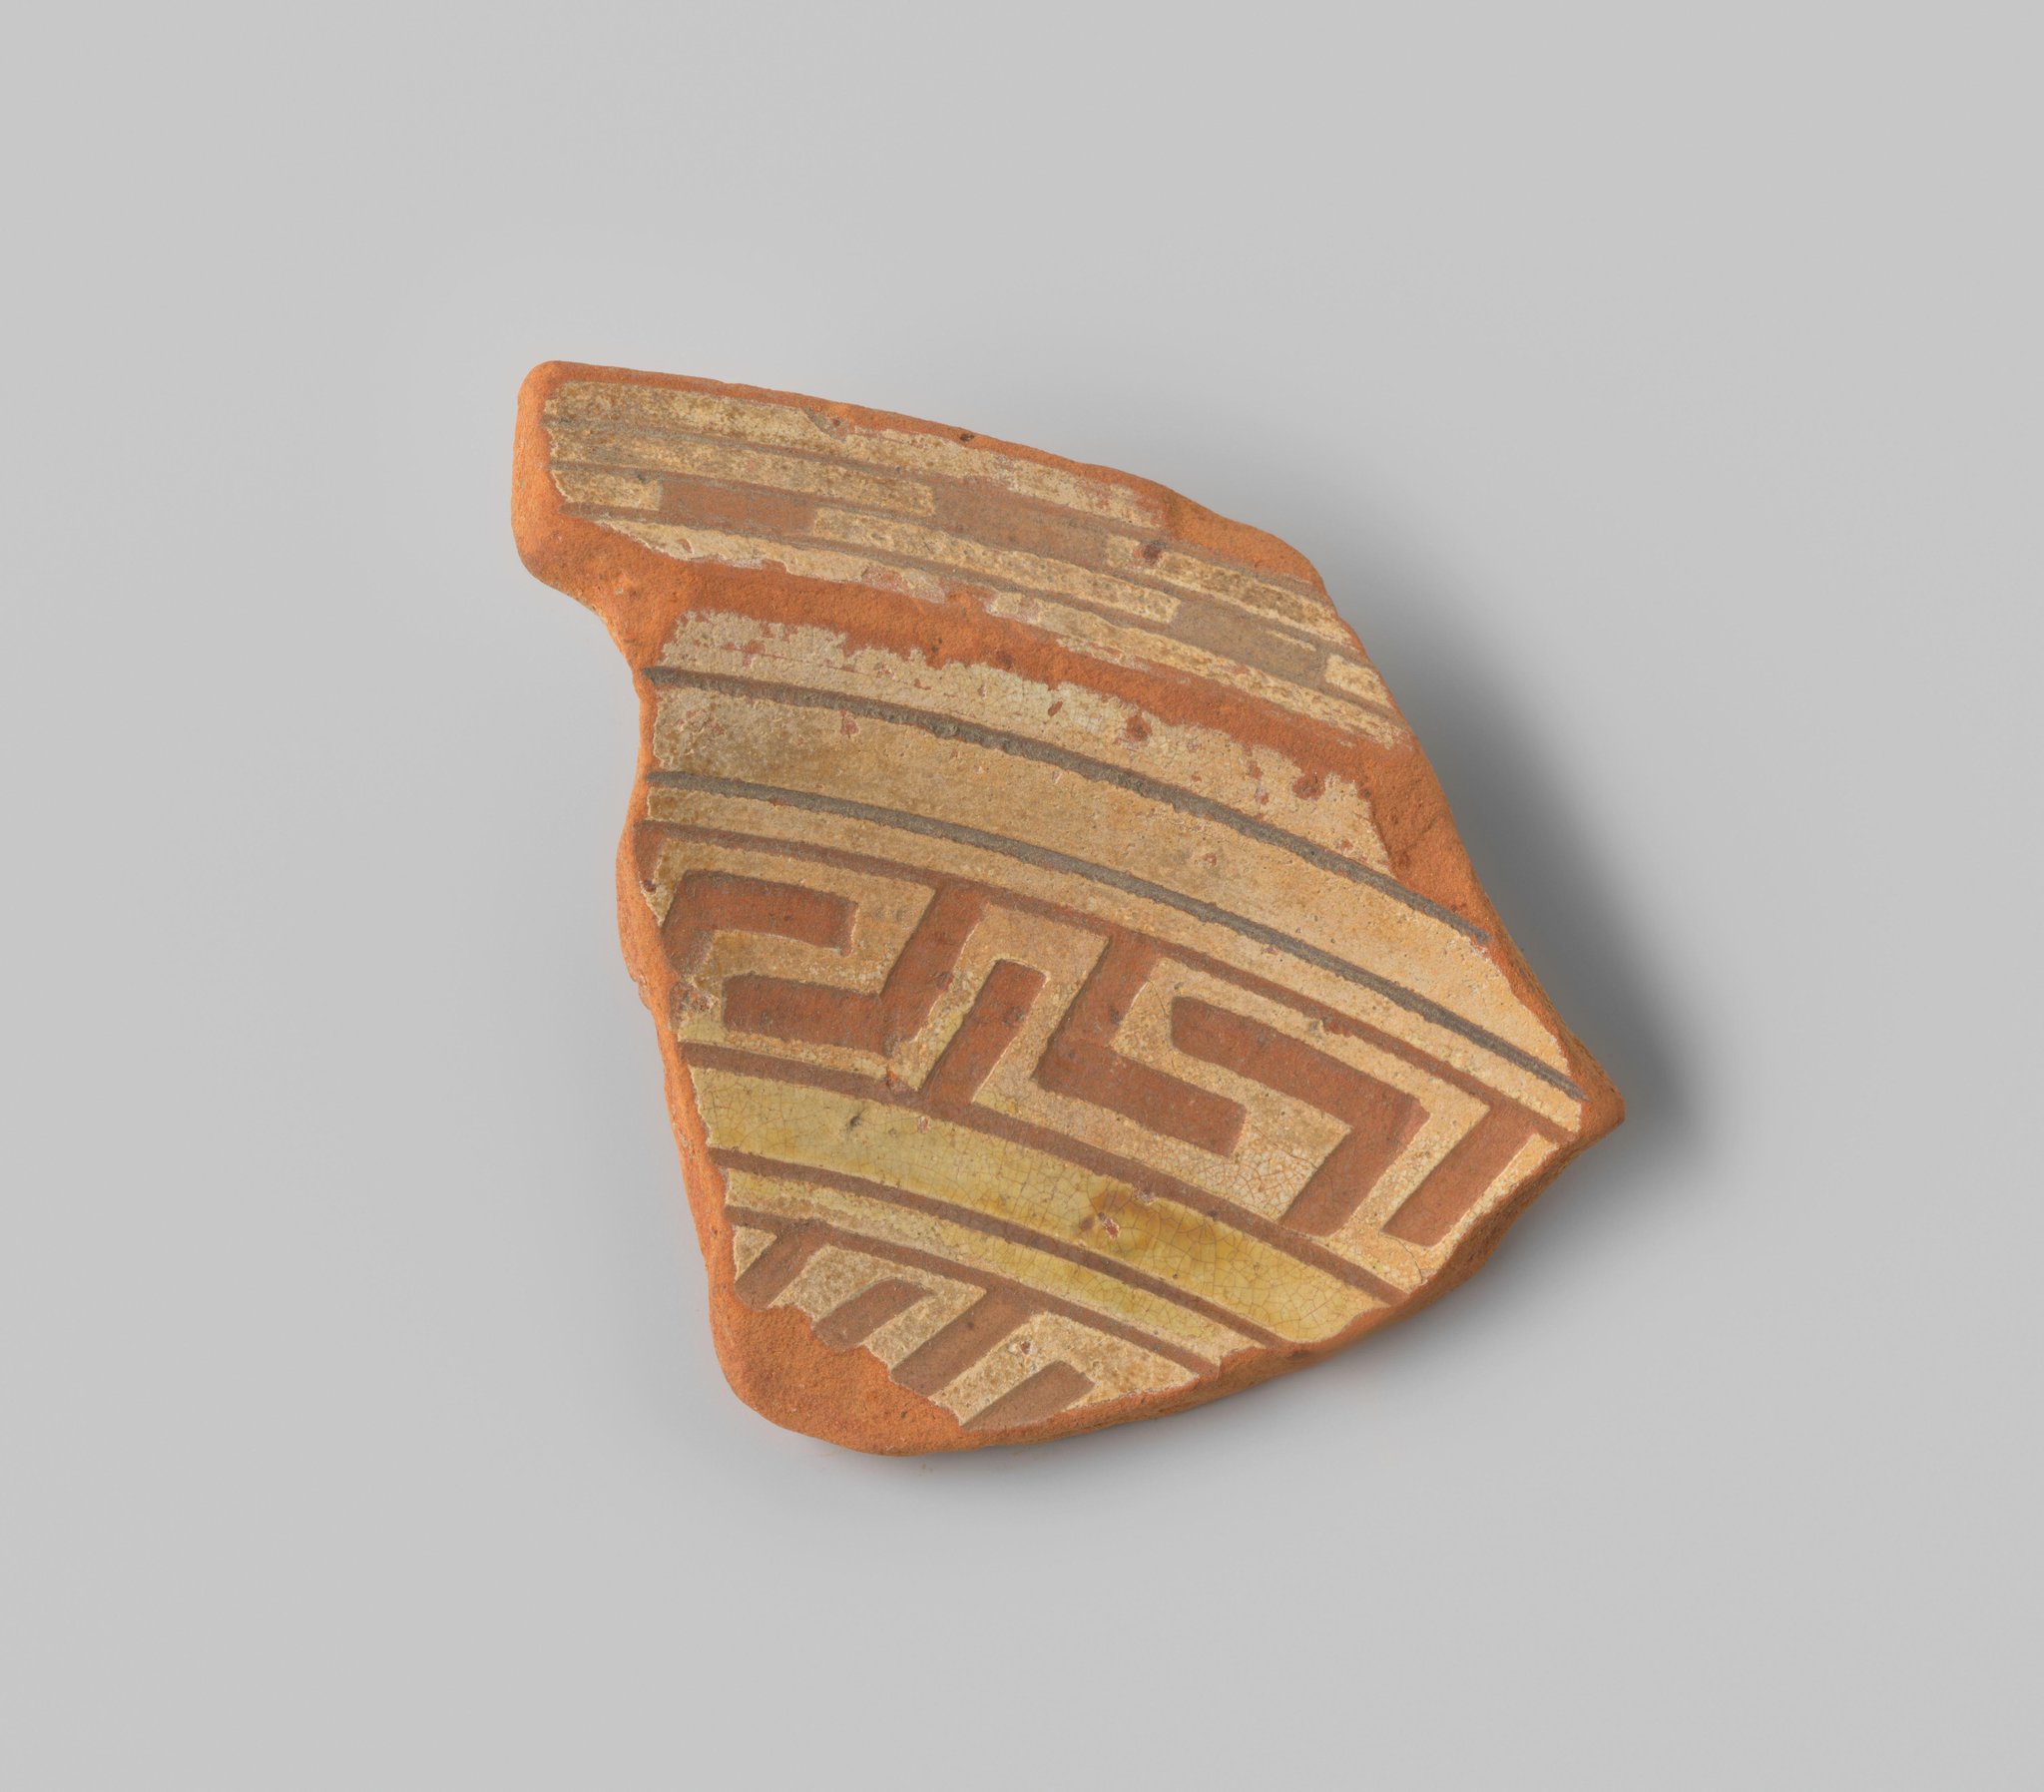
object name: sherd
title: Fragment van een schotel met roodbakkende scherf, waarop aan de voorzijde in sgrafitto-techniek met wit en geel glazuur strepen zijn aangebracht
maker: Anonymous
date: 1200-1899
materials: earthenware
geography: italy